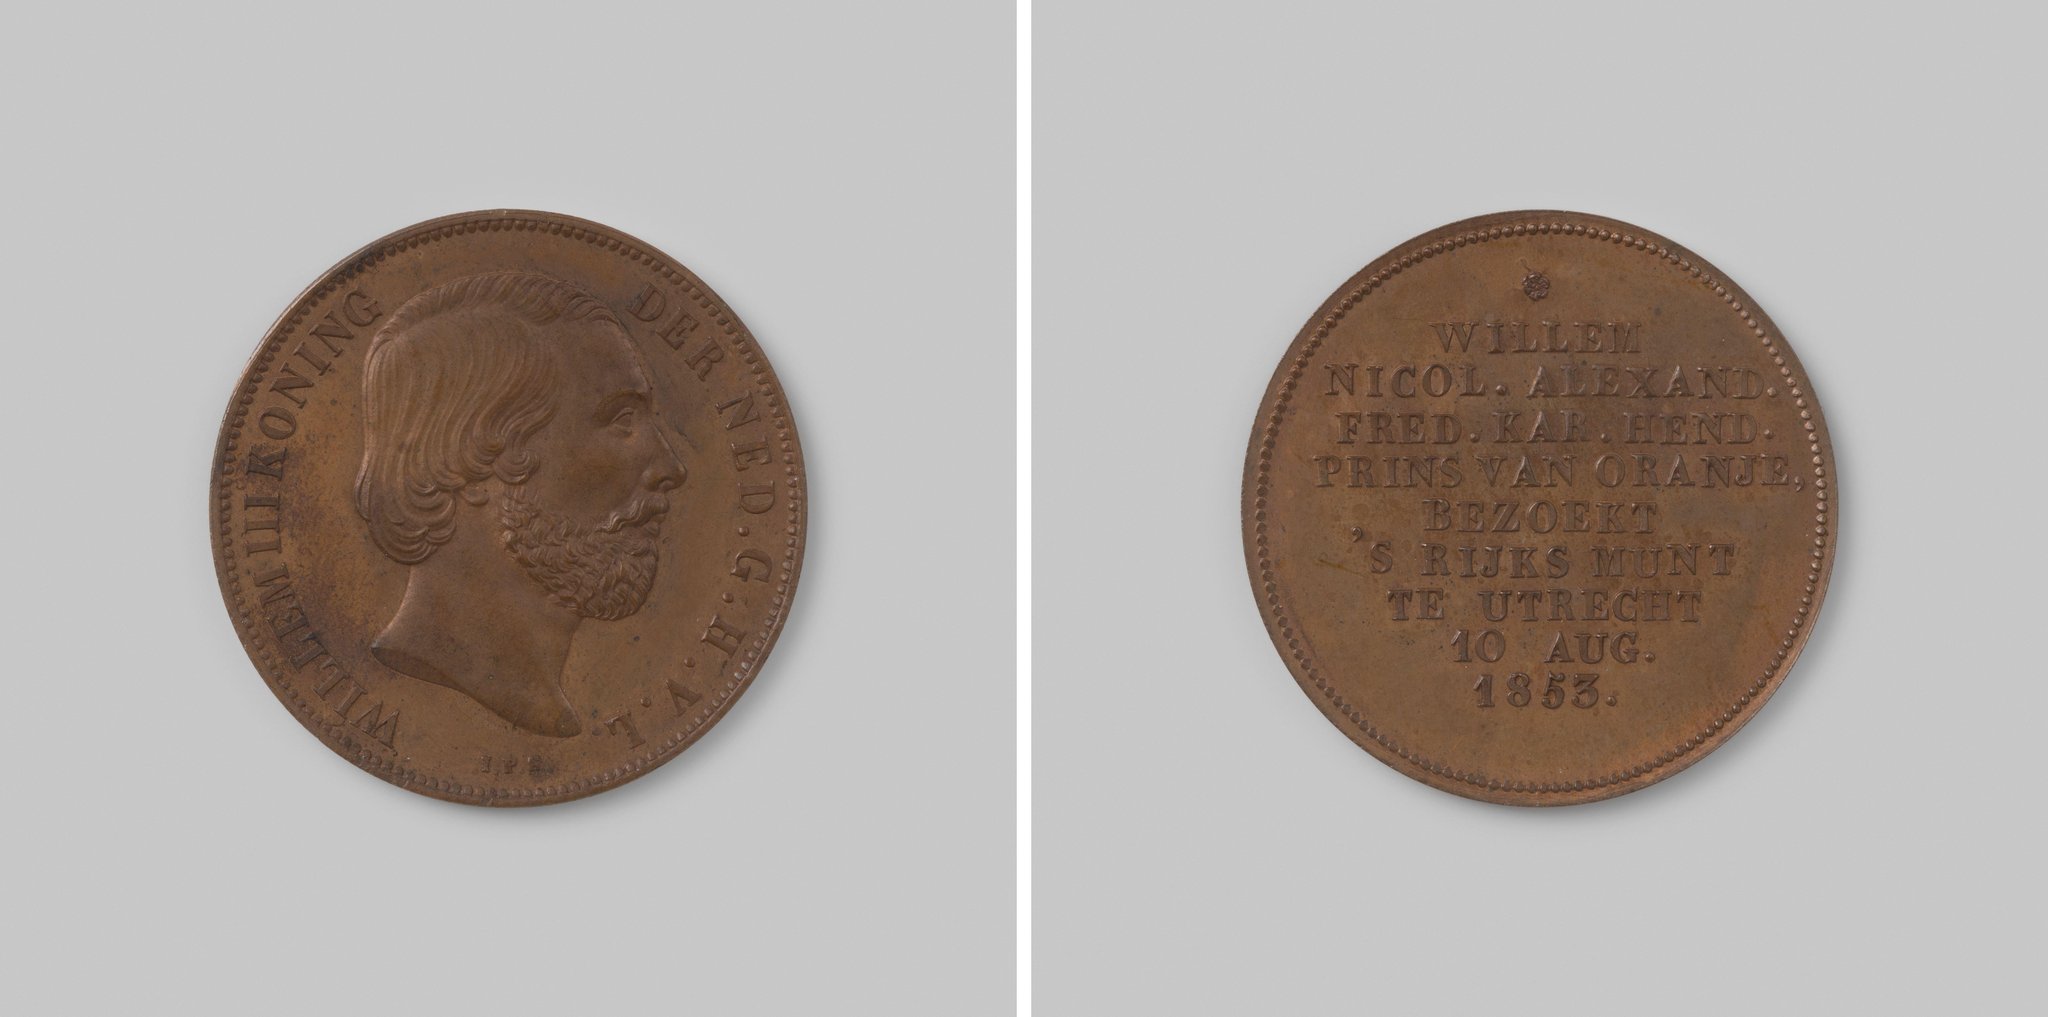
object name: history medal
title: Willem III, koning der Nederlanden bezoekt de Rijksmunt te Utrecht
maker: johannis petrus schouberg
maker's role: die cutter, draughtsman, print maker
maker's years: 1798-1864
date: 1853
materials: bronze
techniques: striking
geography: utrecht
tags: brussels, willem iii (koning der nederlanden), utrecht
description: Bronzen penning. Voorzijde: borststuk man binnen omschrift. Keerzijde: opschrift